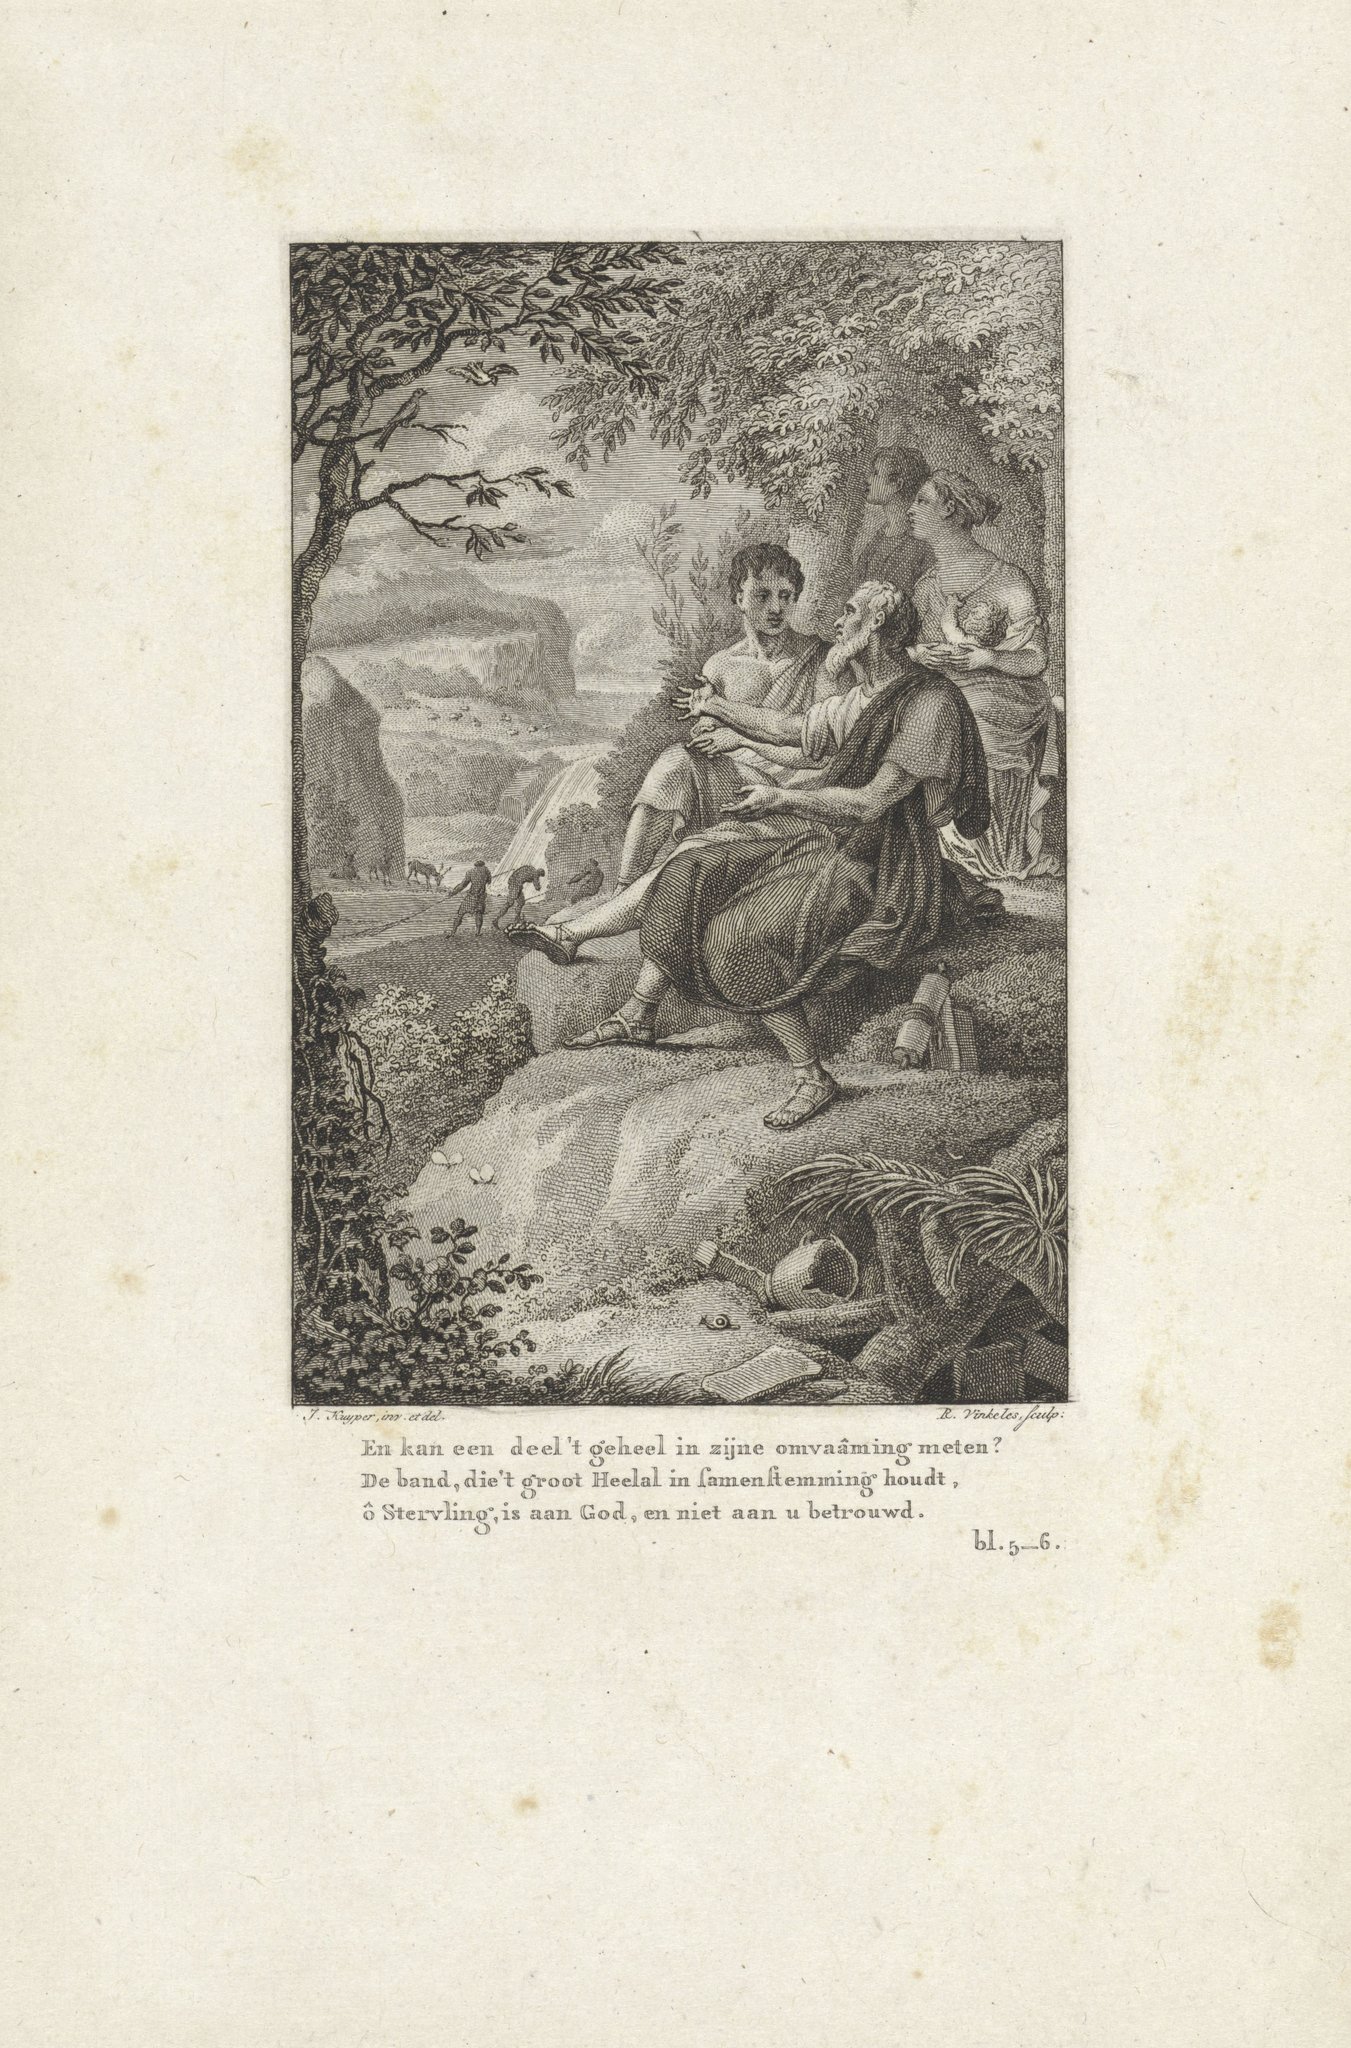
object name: print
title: Berglandschap met twee mannen die een gesprek voeren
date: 1807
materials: paper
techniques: engraving, etching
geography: amsterdam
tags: (high) hill, conversation, dialogue; conversation piece, landscapes (+ landscape with figures, staffage)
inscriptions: collector's mark: Lugt 2228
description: Deze prent is ook gebruikt als illustratie voor: Bilderdijk, Willem. De Mensch: Popes Essay on men. Amsterdam: Johannes Allart, 1807, p. 5-6.